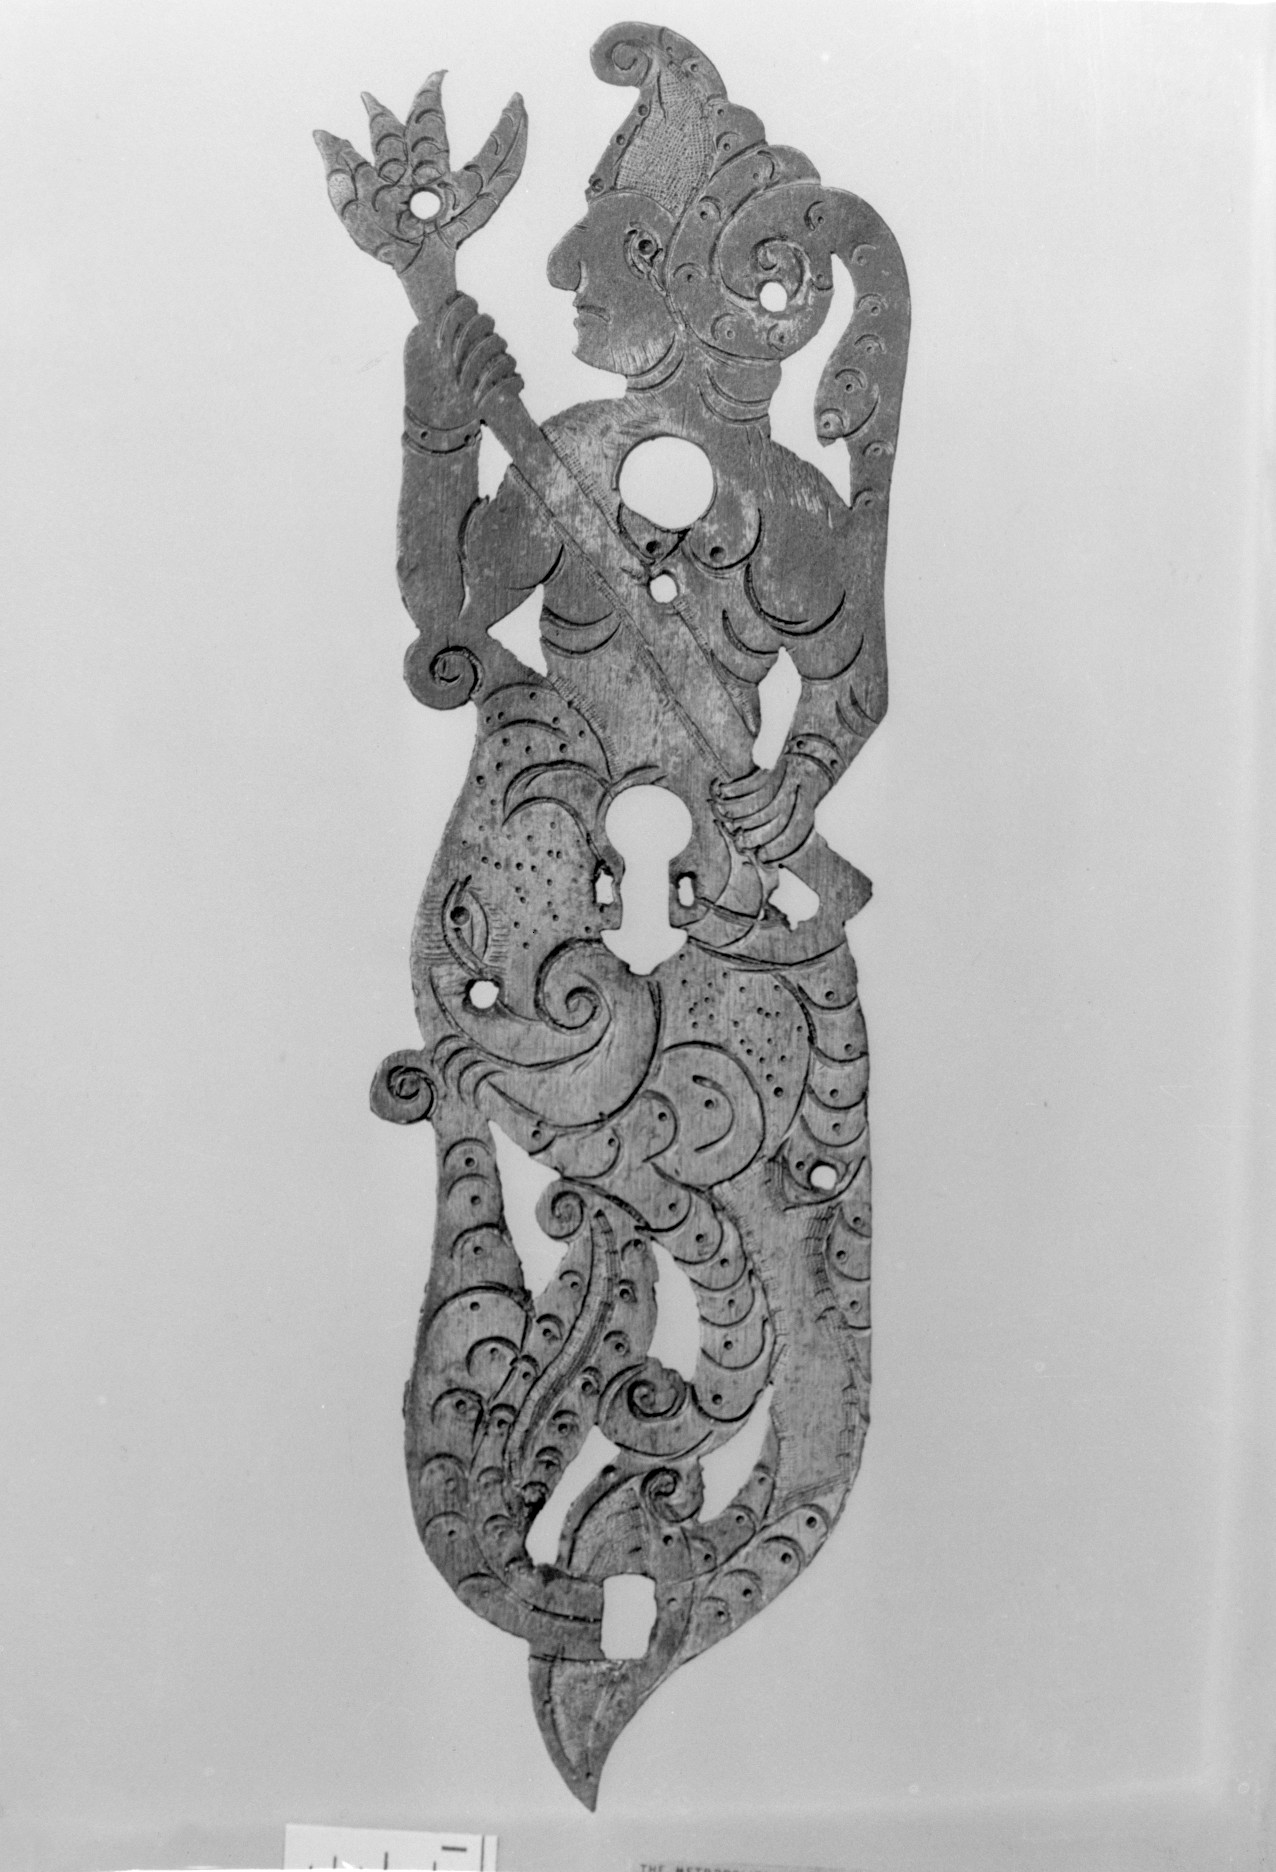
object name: keyhole escutcheon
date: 1501-1600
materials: iron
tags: women